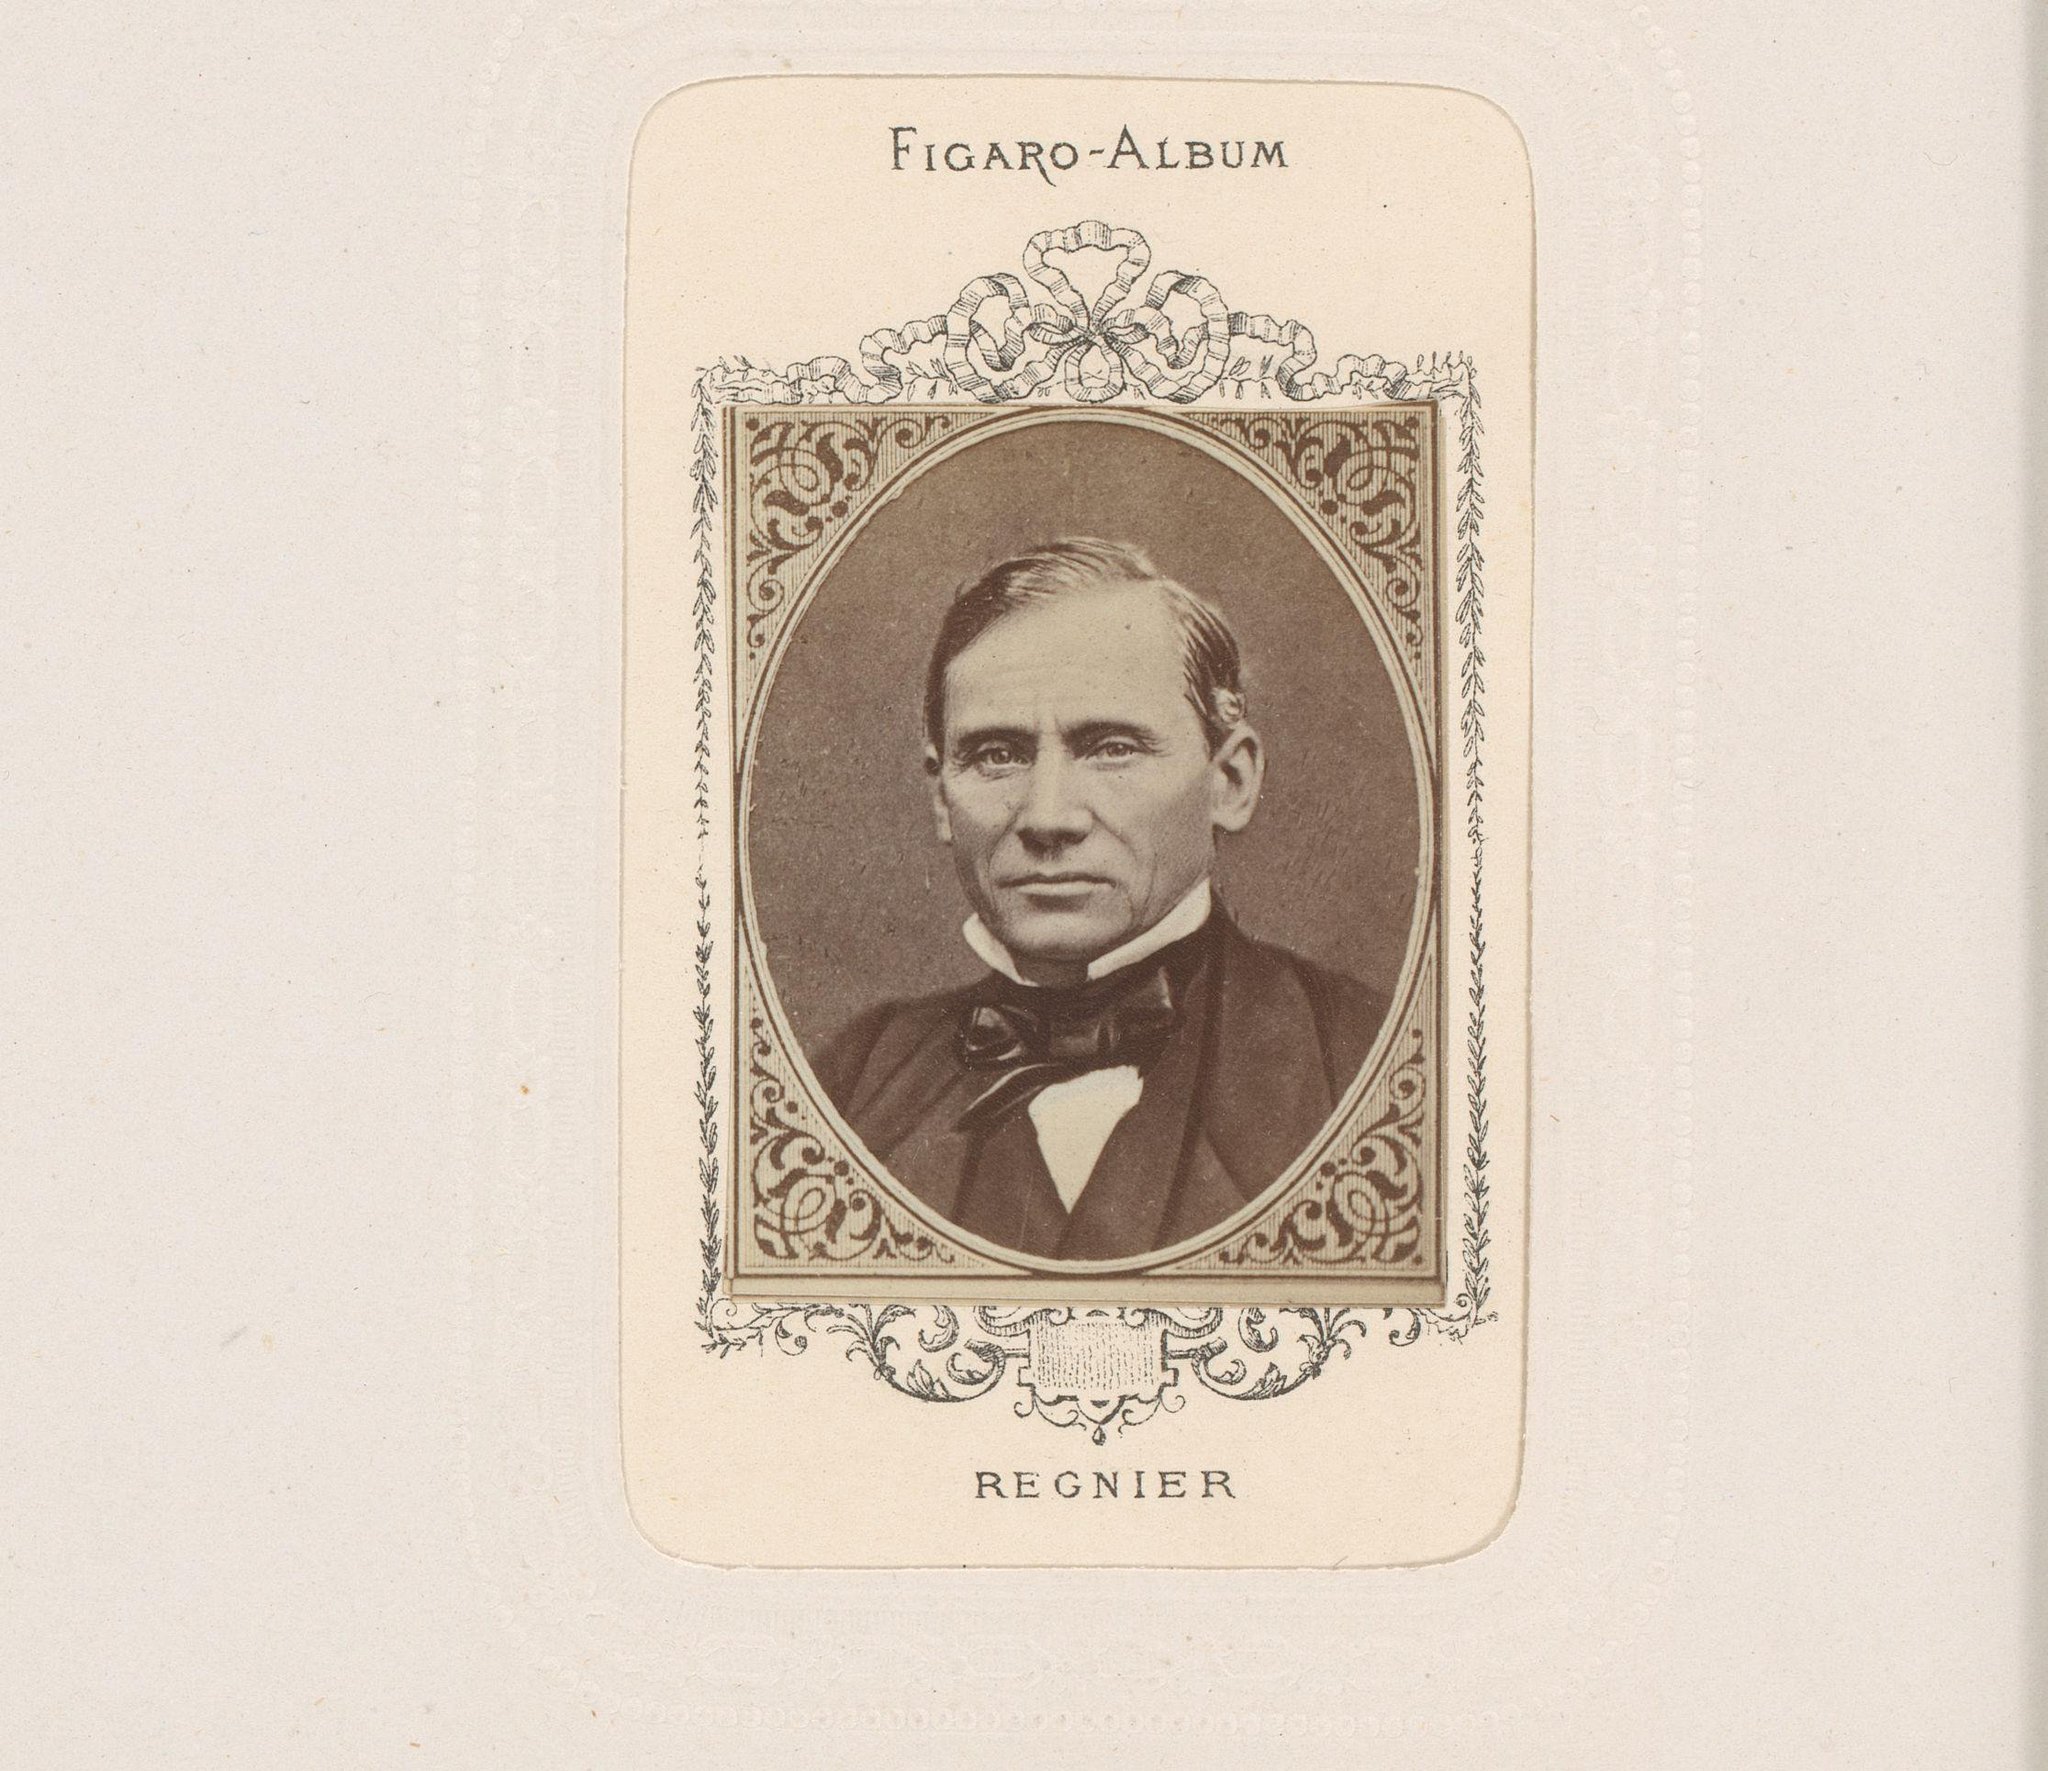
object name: album leaf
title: Fotoreproductie van een portret van François Joseph Regnier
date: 1860-1900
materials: cardboard, photographic support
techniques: albumen print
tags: historical persons, portrait of actor, actress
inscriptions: inscription: ‘Figaro-Album/ Regnier/ d'après Carjat Phot.’